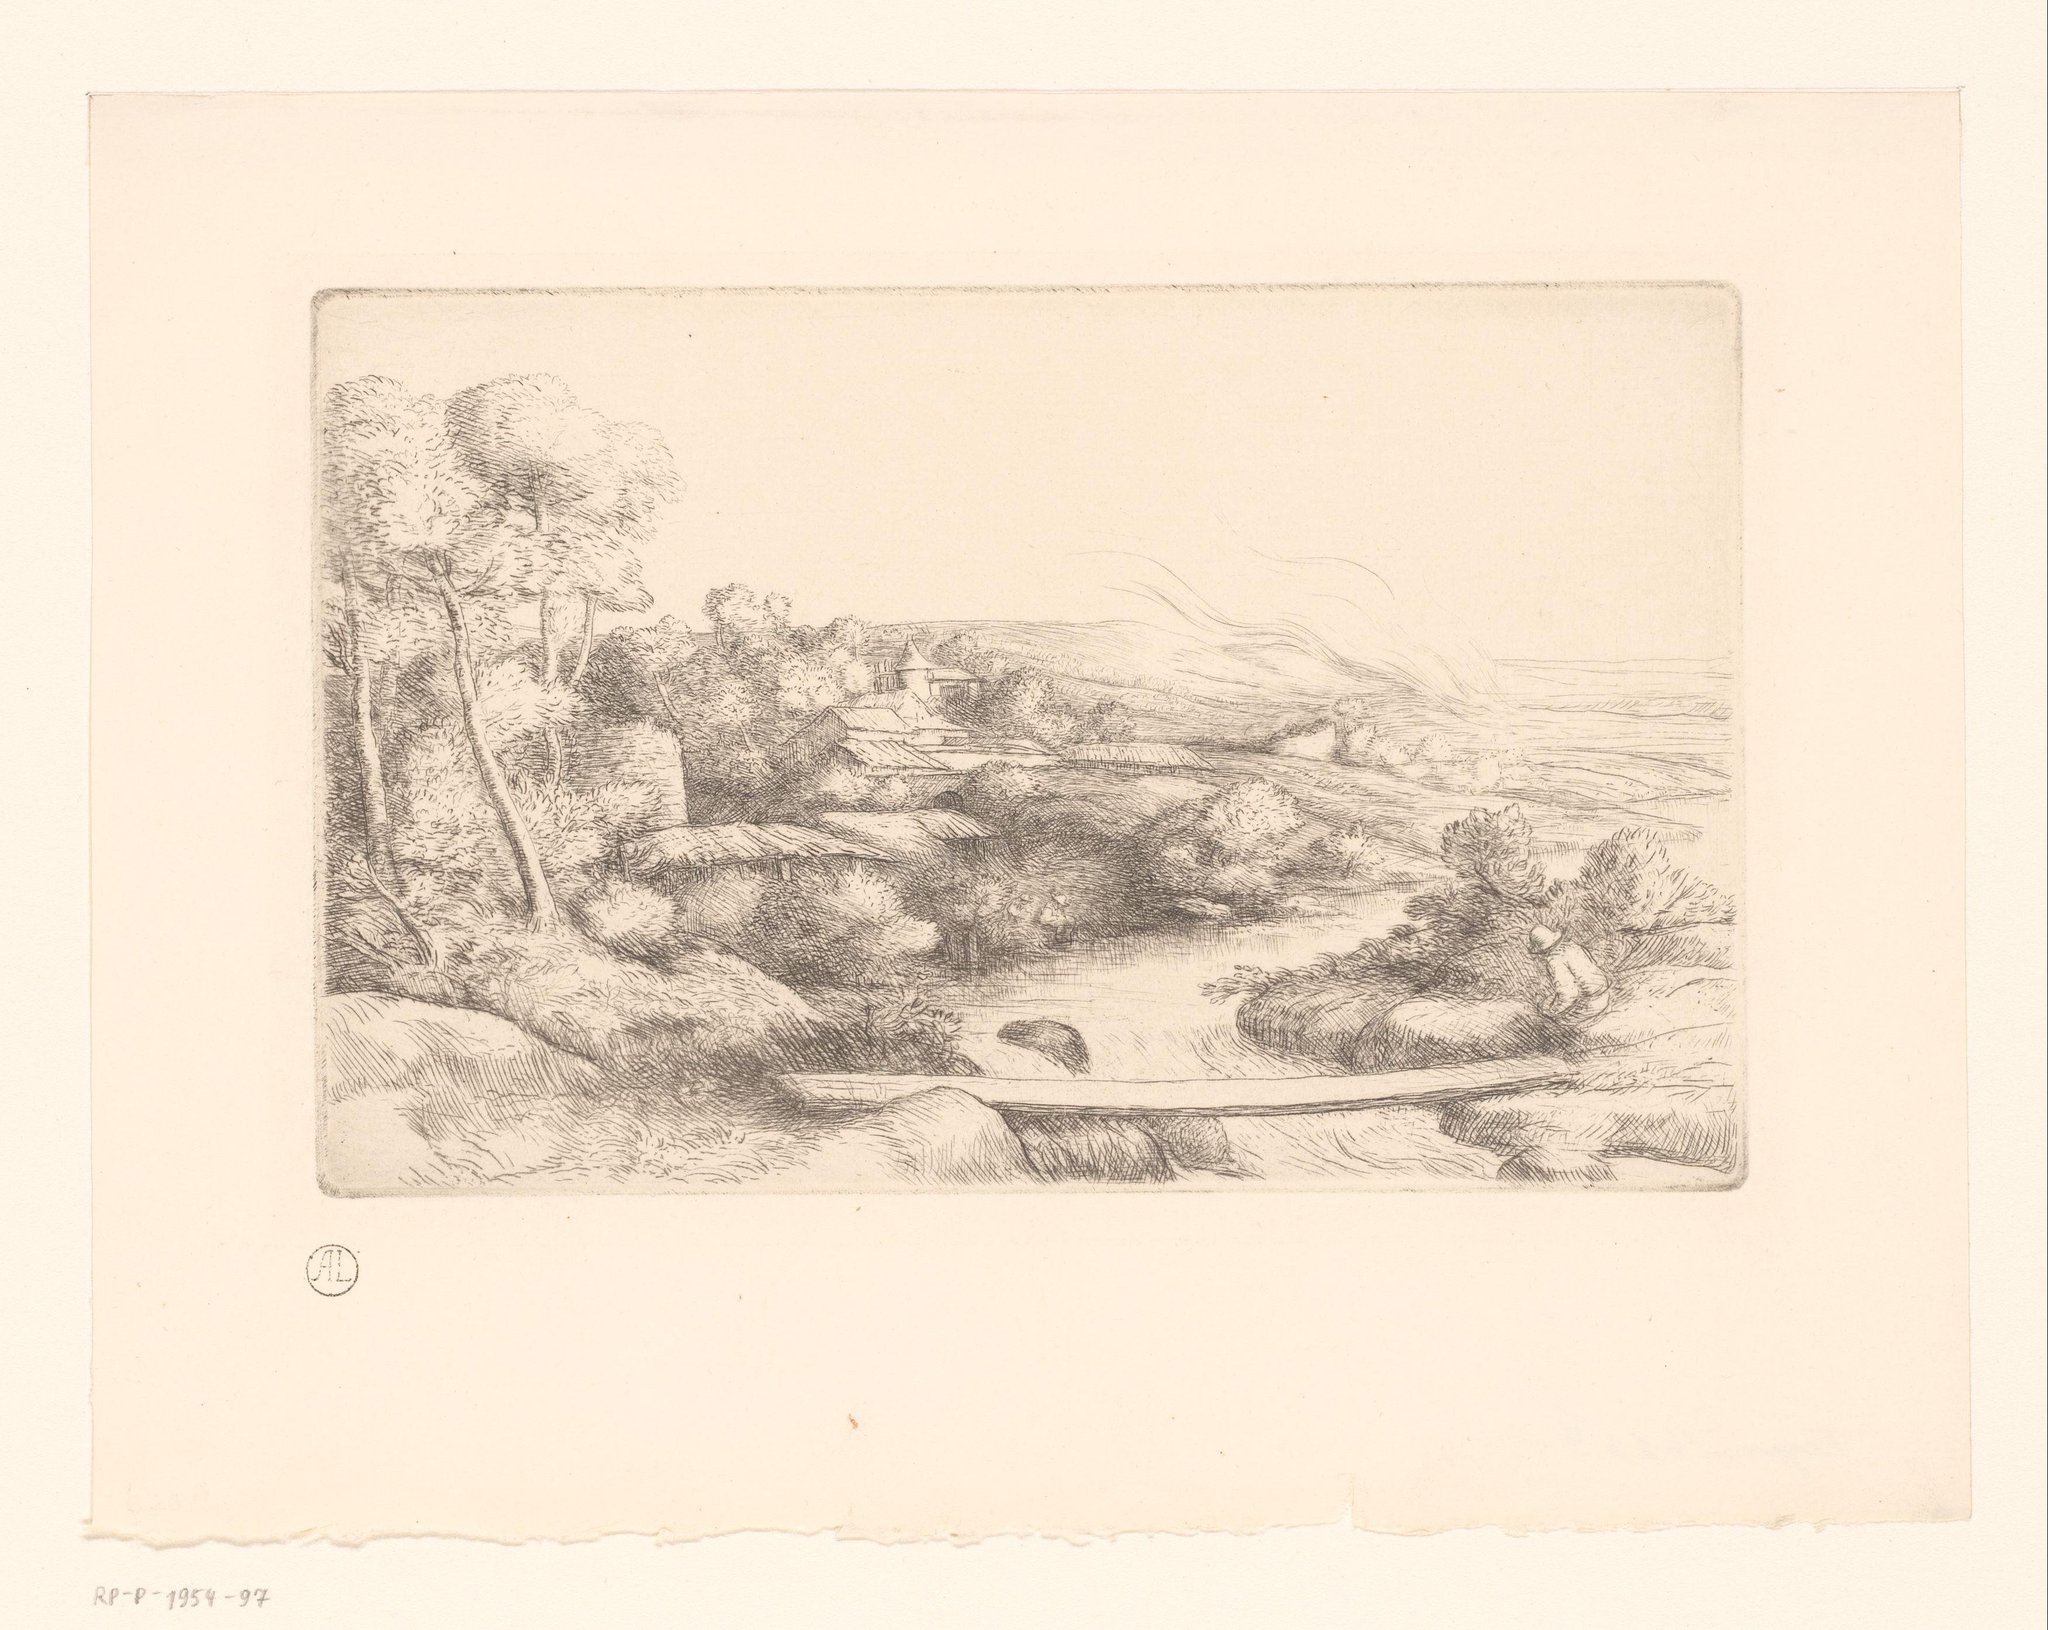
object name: print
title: La passerelle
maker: alphonse legros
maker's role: print maker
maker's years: 1837-1911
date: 1847-1911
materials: paper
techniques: engraving, etching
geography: france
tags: river, landscape with bridge, viaduct or aqueduct - ii - ideal landscapes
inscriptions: collector's mark: Lugt 2228, collector's mark: Lugt 2760, collector's mark: Lugt 140a